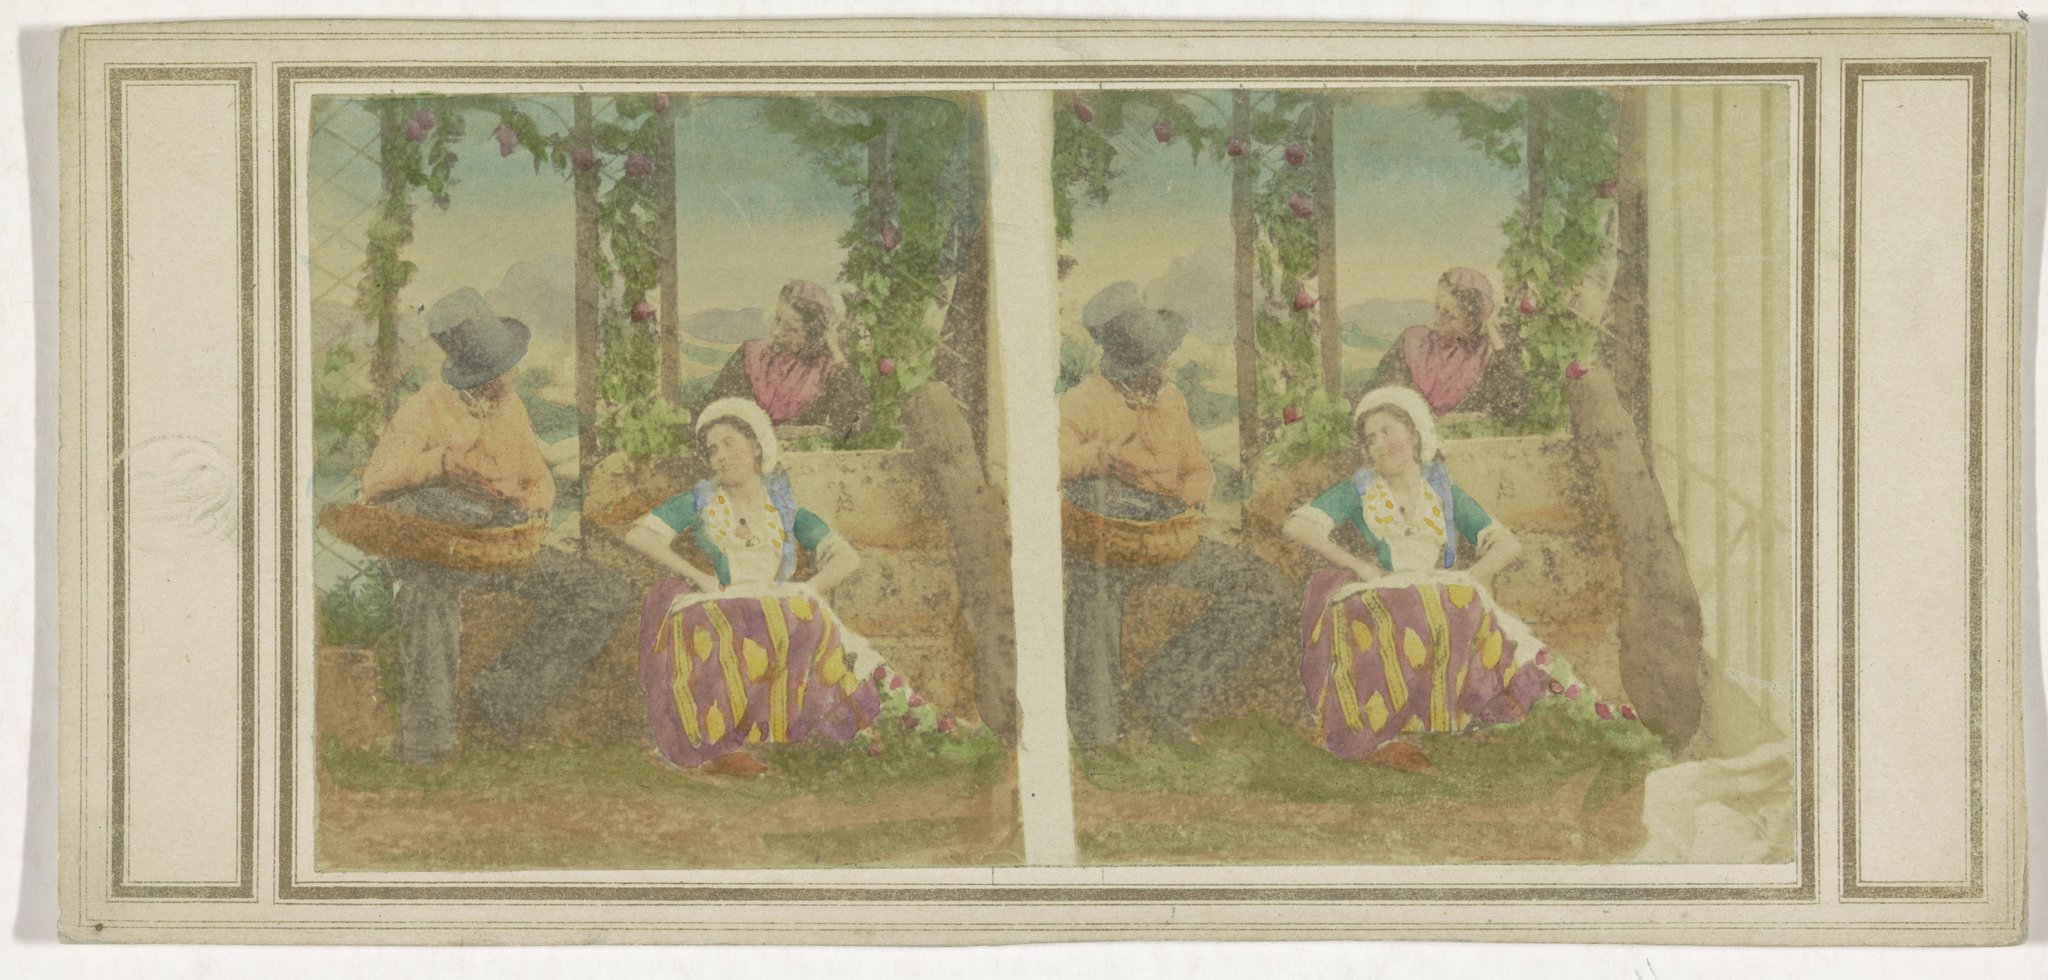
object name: stereograph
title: Man met een mand zittend naast twee vrouwen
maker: pierre-ambroise richebourg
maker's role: fotograaf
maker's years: 1810-1875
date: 1850-1870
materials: photographic support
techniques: albumen print, hand coloring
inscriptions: check stamp: ‘monogram LM (?)’, number: ‘2’, number: ‘238’